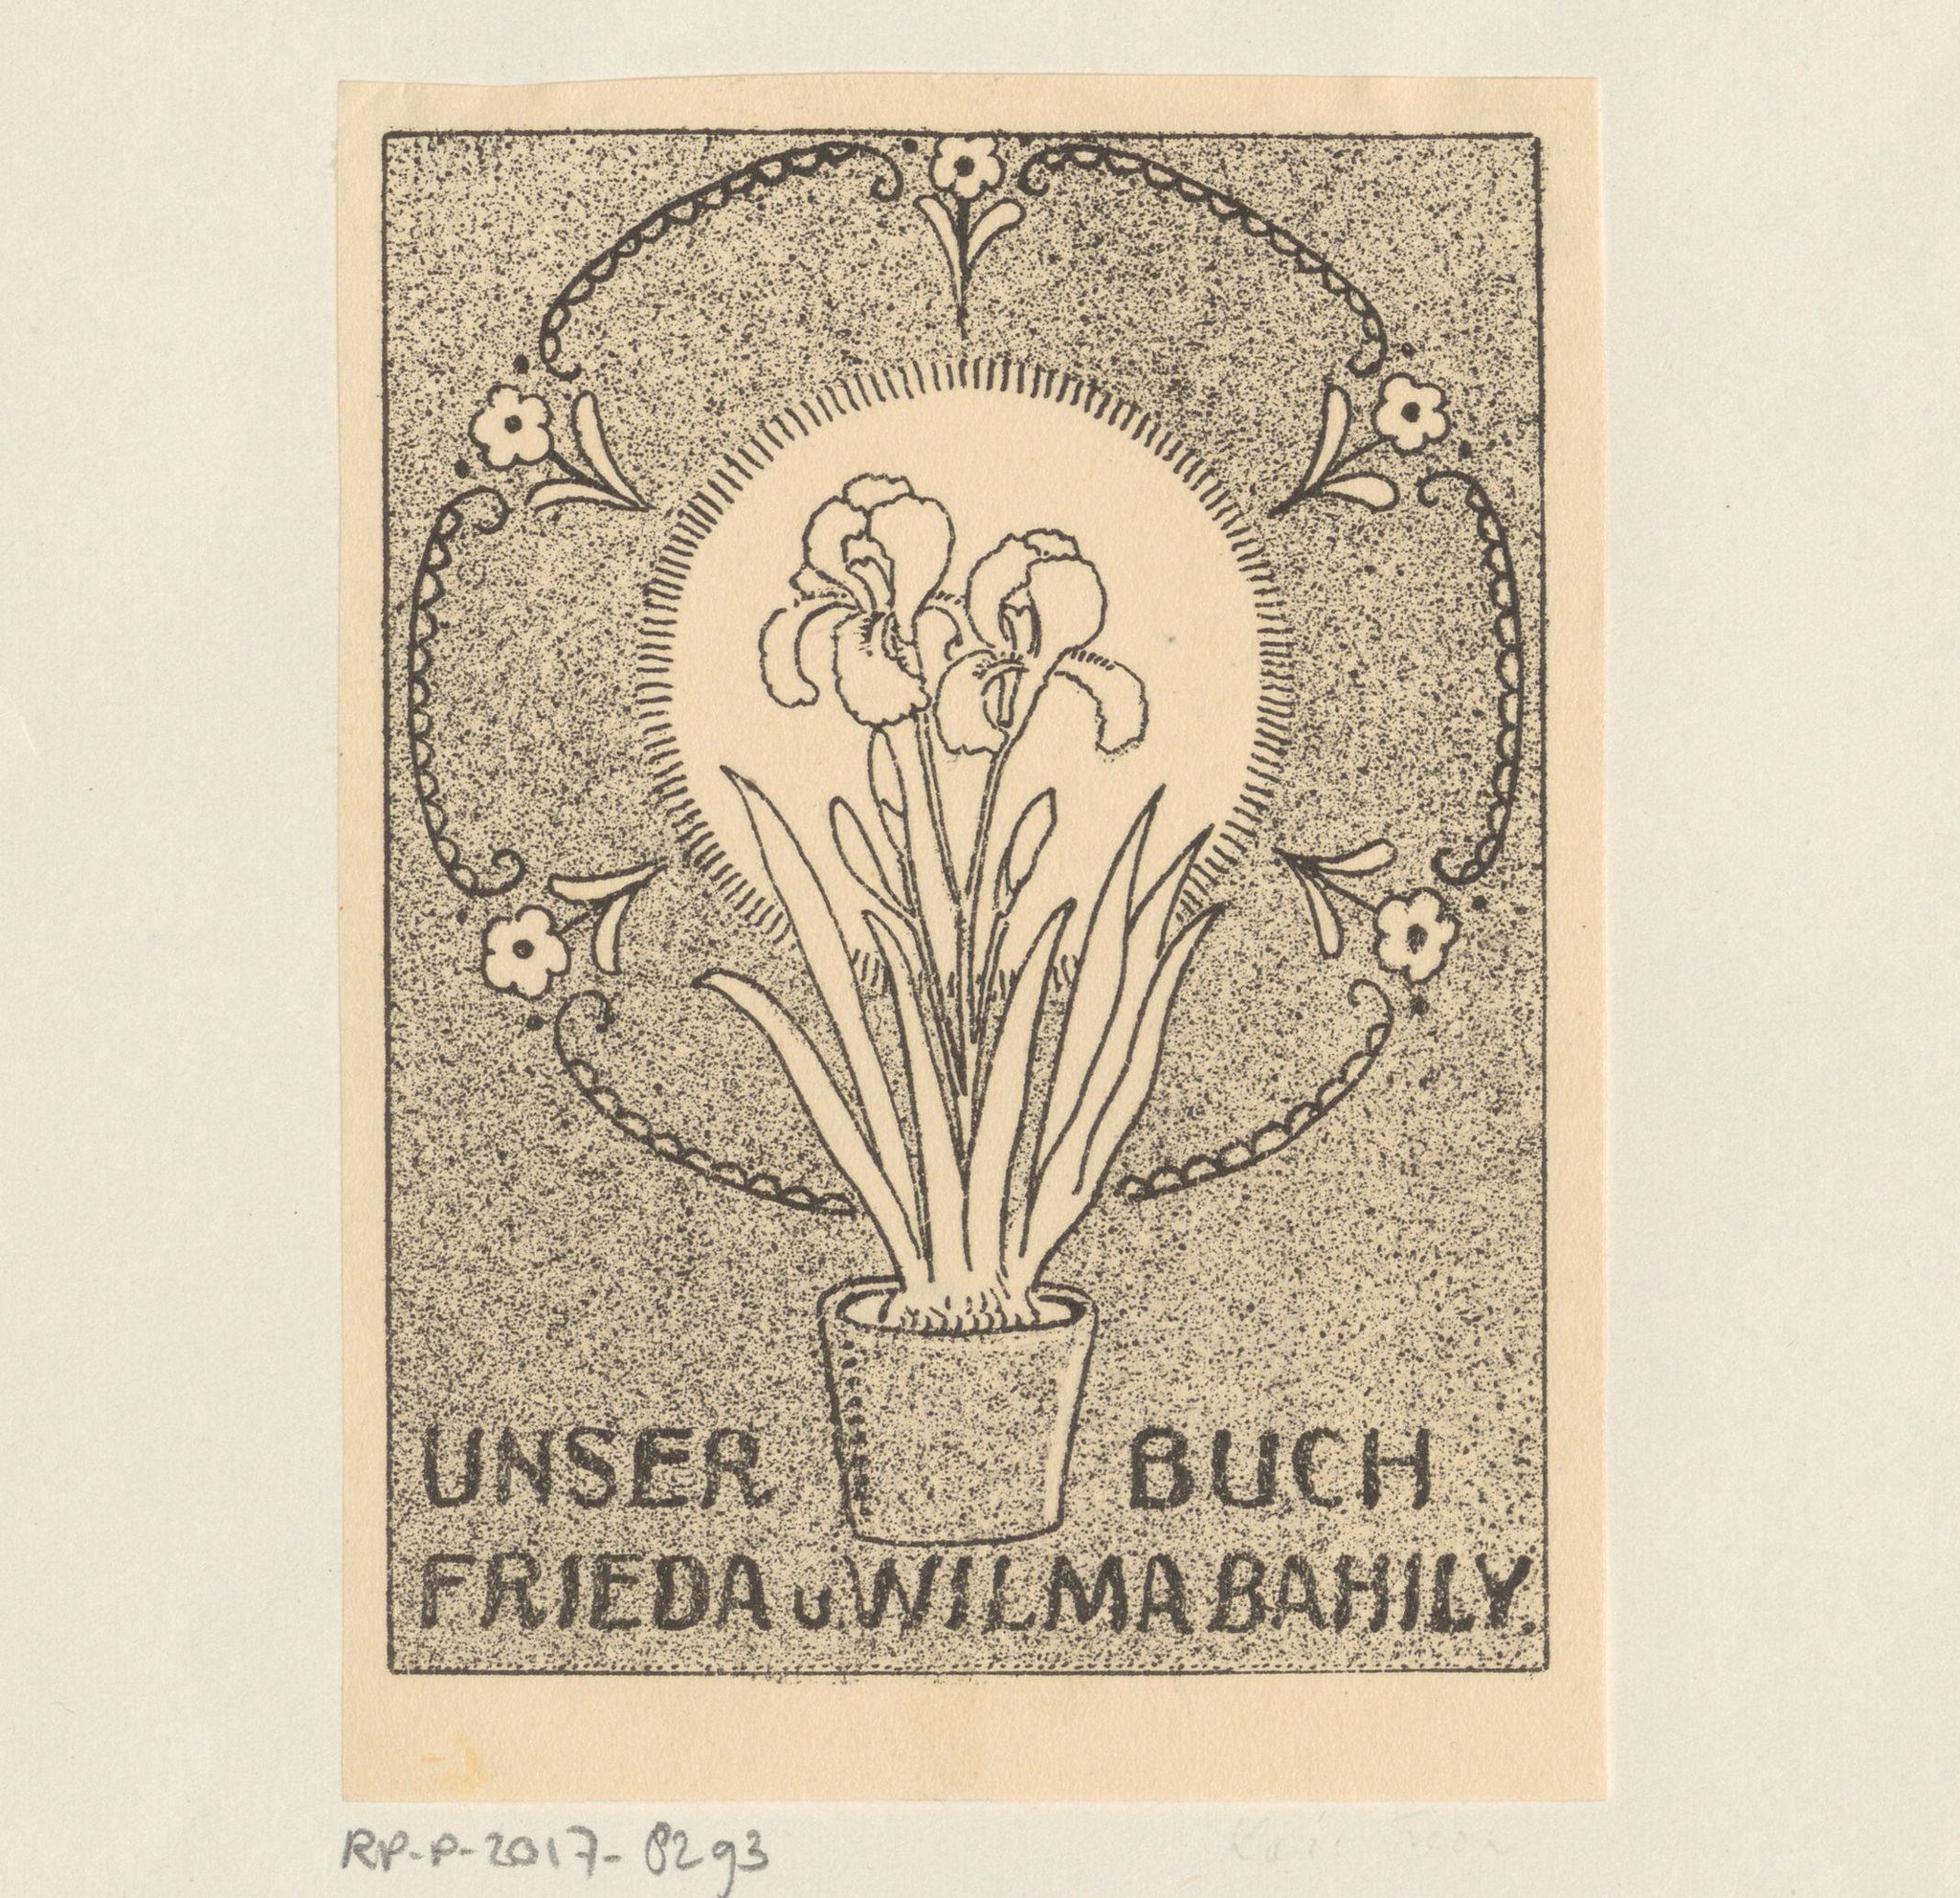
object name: bookplate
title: Ex libris van Frieda en Wilma Bahily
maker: karl hugo frech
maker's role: print maker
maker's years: 1883-1945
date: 1893-1945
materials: paper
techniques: lithograph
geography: bratislava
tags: flowers: iris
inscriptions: workshop stamp: ‘Karl Frech/ Maler-Graphiker/ Bratislava - Pressburg/ Simonyi Ivan Rad. 6.’